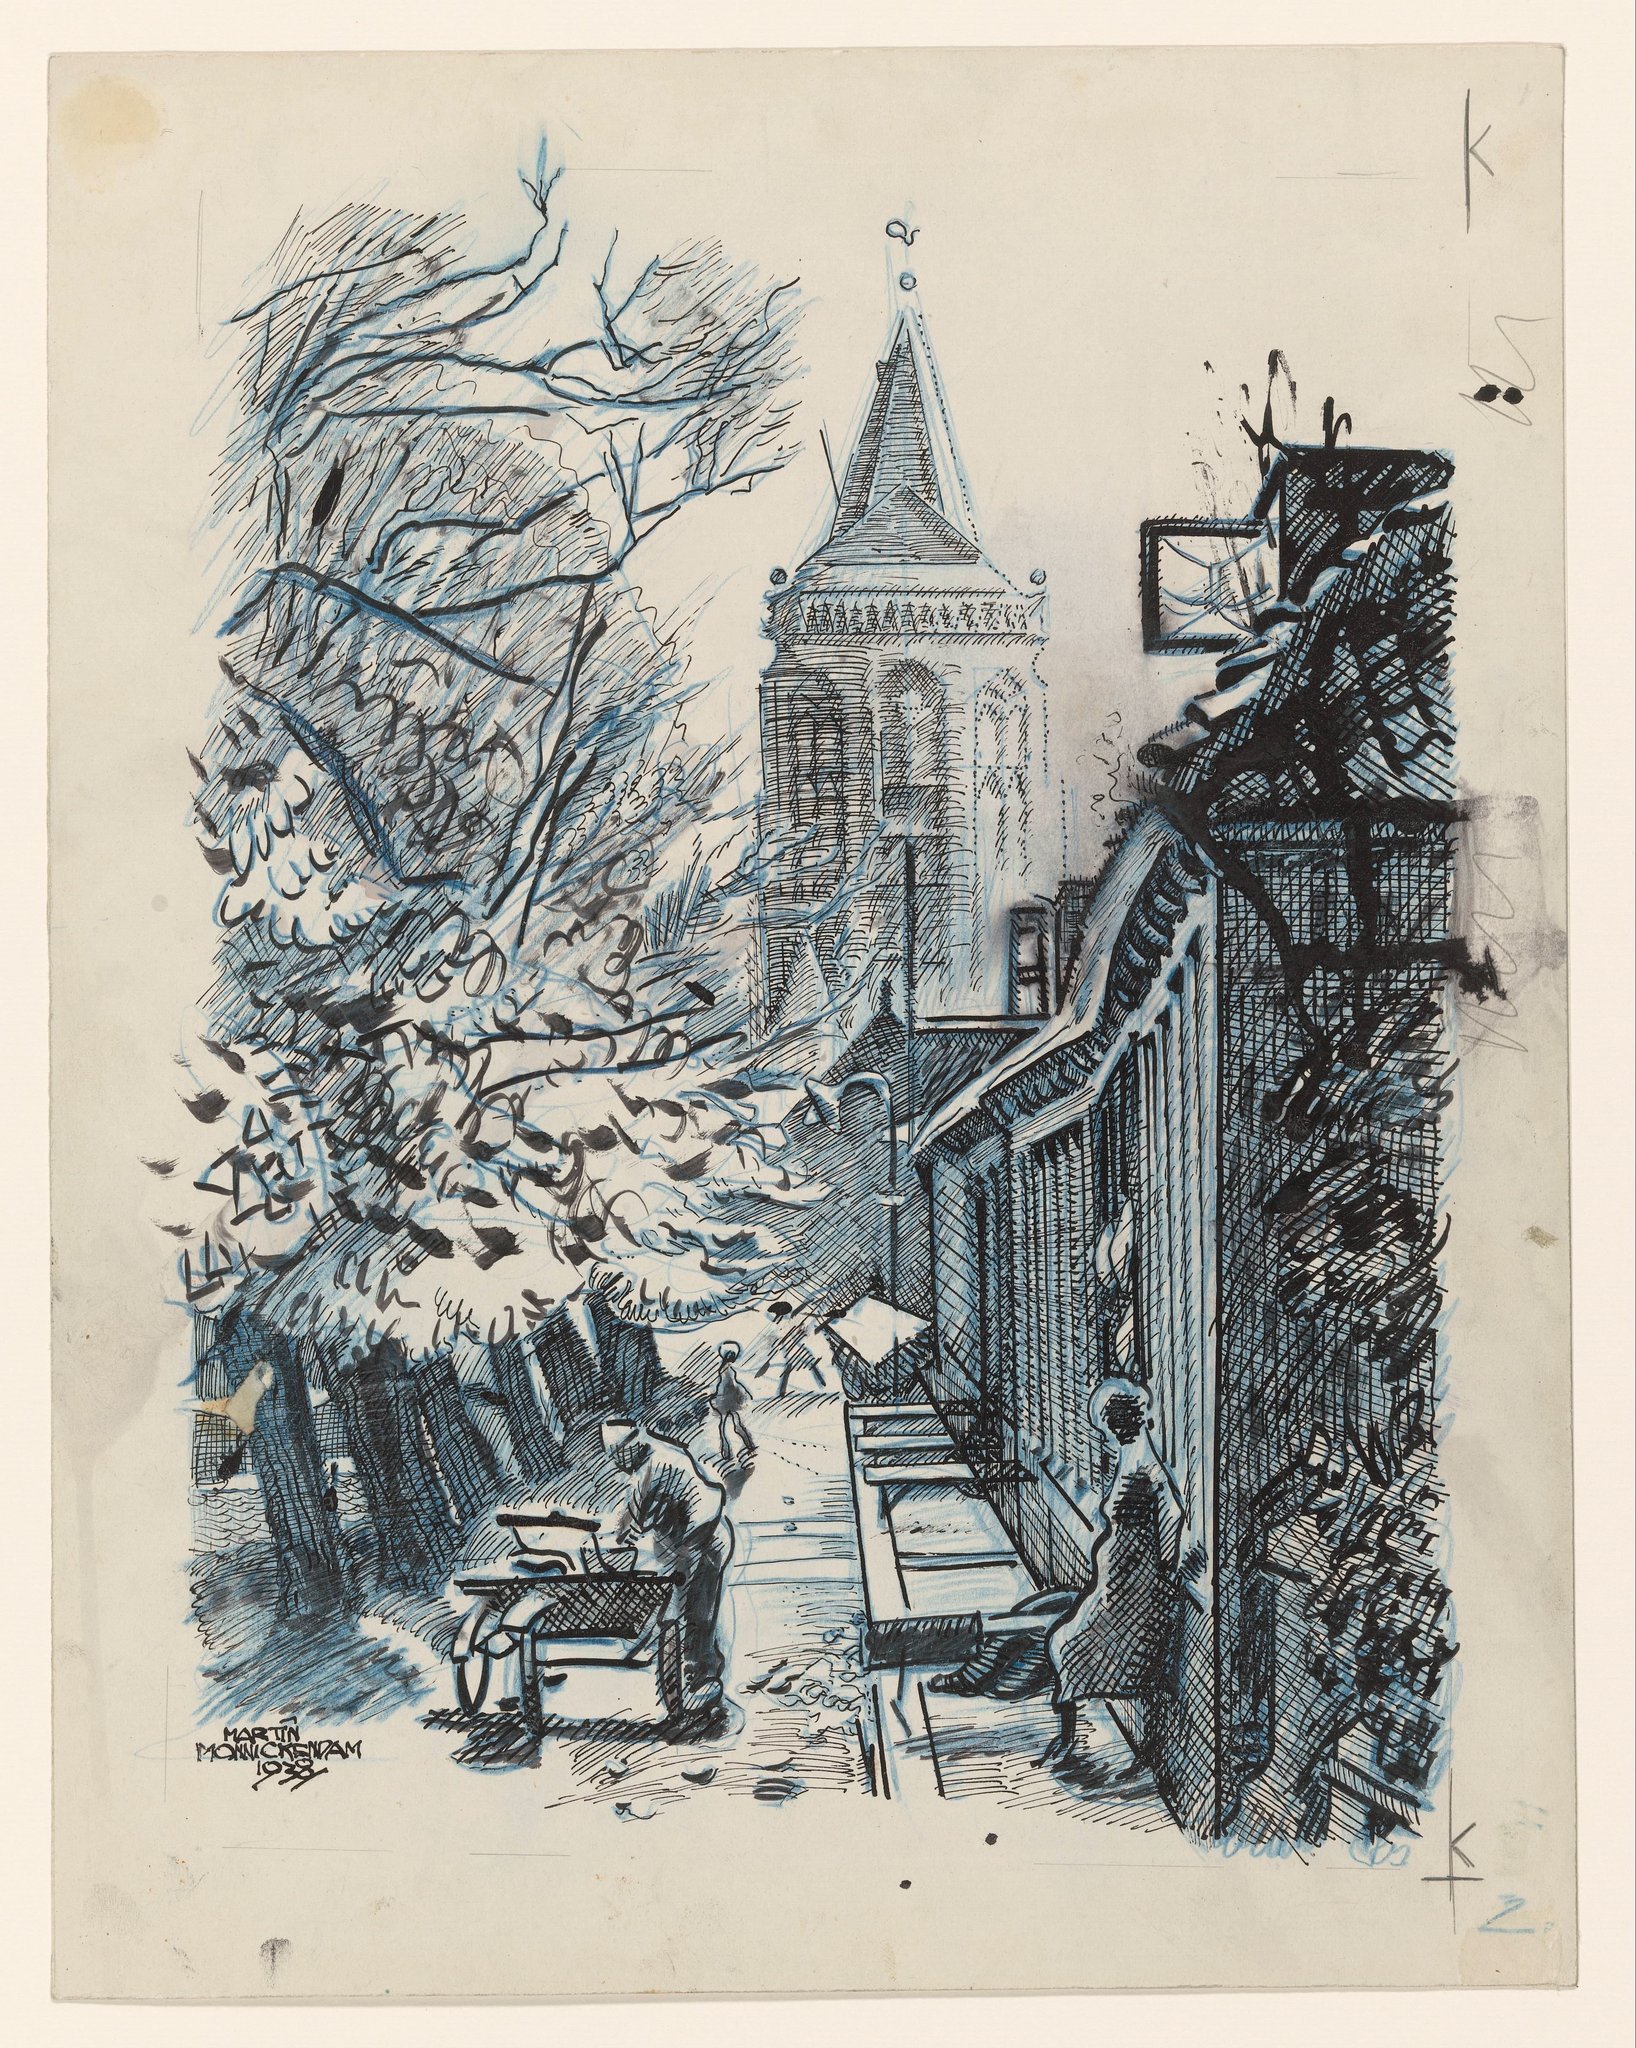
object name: drawing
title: Straatje met gezicht op de St. Nicolaaskerk te Monnickendam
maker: martin monnickendam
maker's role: draughtsman, painter, print maker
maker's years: 1874-1943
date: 1938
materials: ink, paper, pencil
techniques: pen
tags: church (exterior), street